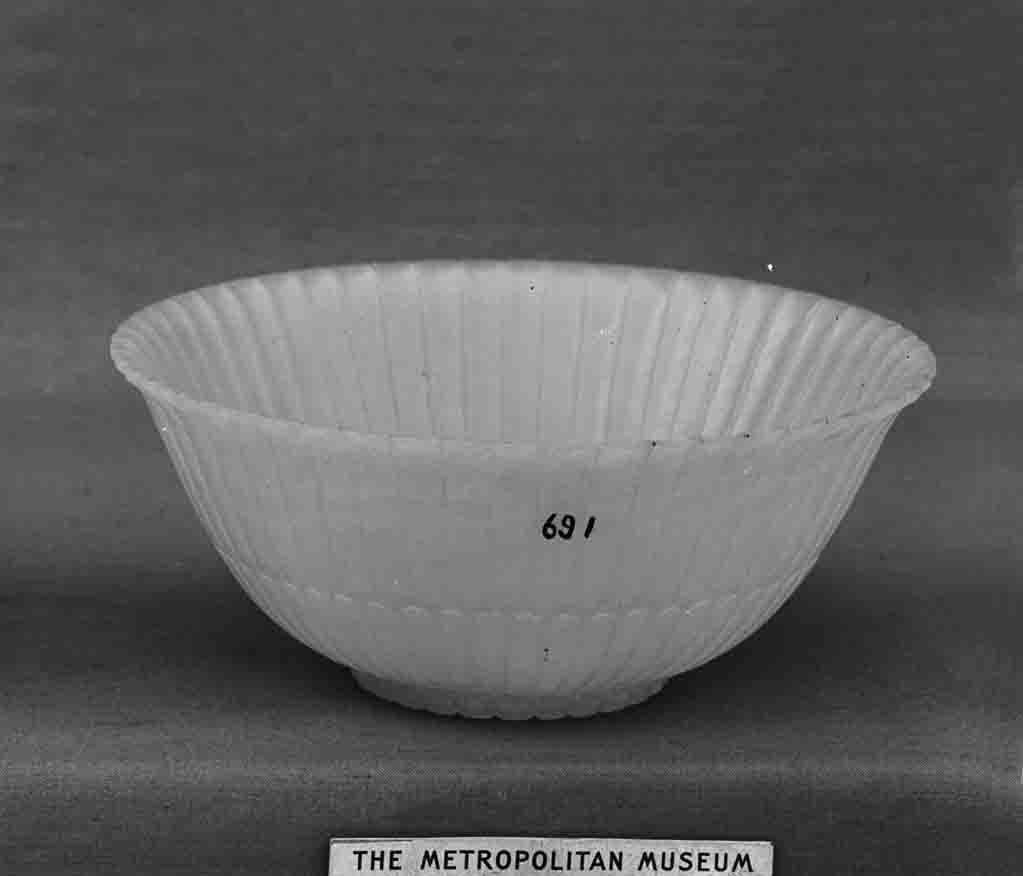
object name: one of pair of rice bowl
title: One of Pair of Rice Bowls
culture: chinese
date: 1736-1795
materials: jade